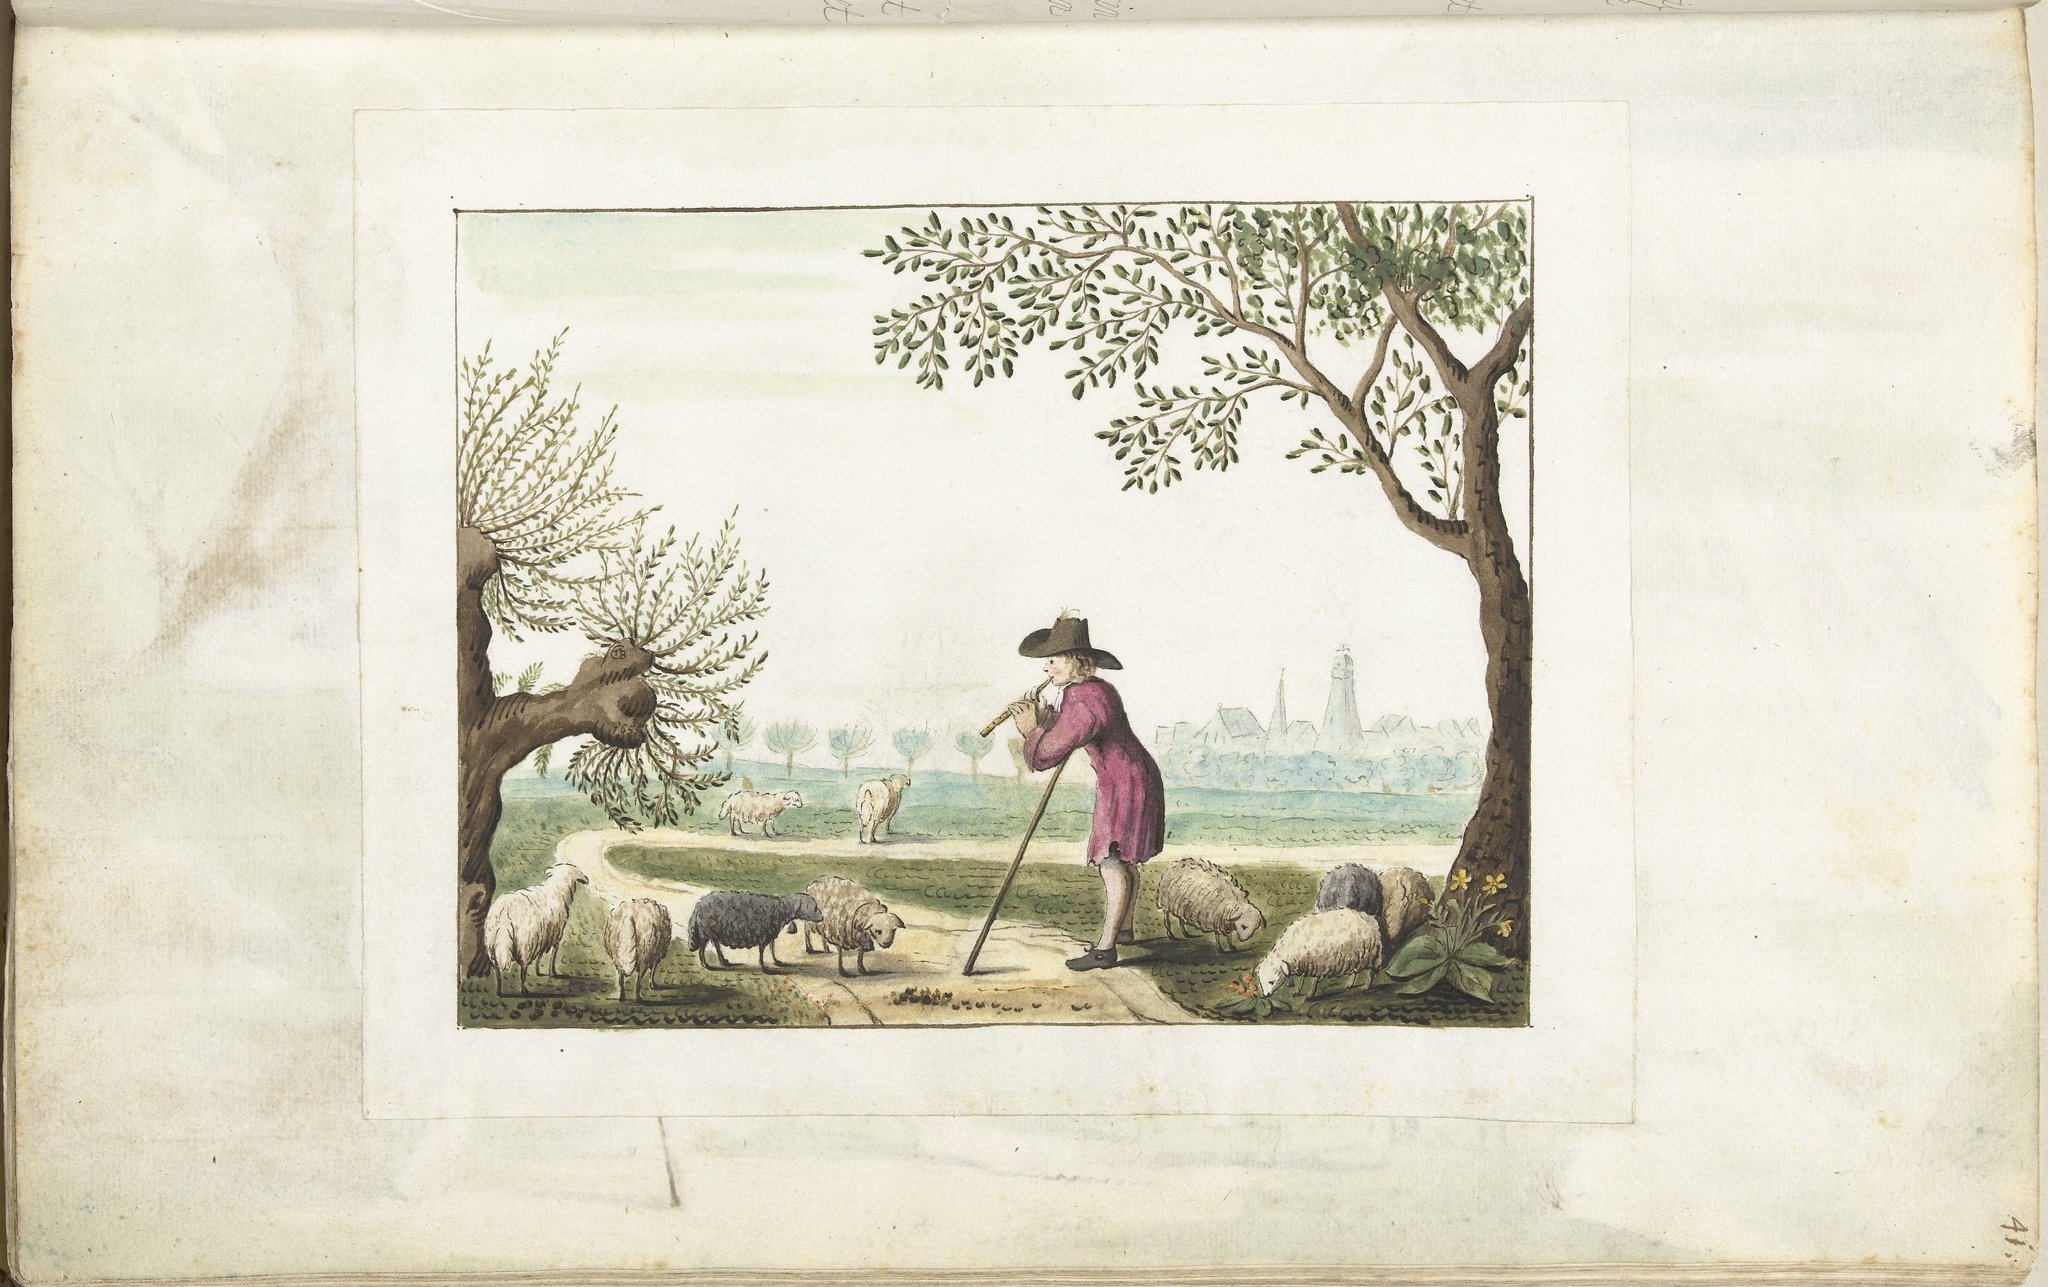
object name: drawing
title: Herder fluitspelend bij zijn schapen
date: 1654-1655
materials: ink, paper, watercolor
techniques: brush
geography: zwolle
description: De tekening is opgeplakt in het Poëzie-album. De stijl lijkt erg op die van de tekening op folio 89 (BI-1890-1952-89(R)), ook het formaat is ongeveer gelijk, mogelijk zijn beide tekeningen afkomstig uit hetzelfde schetsboek.